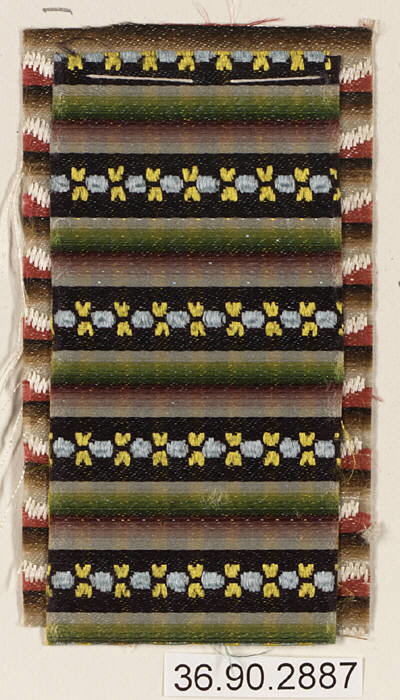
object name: piece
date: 1801-1900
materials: silk